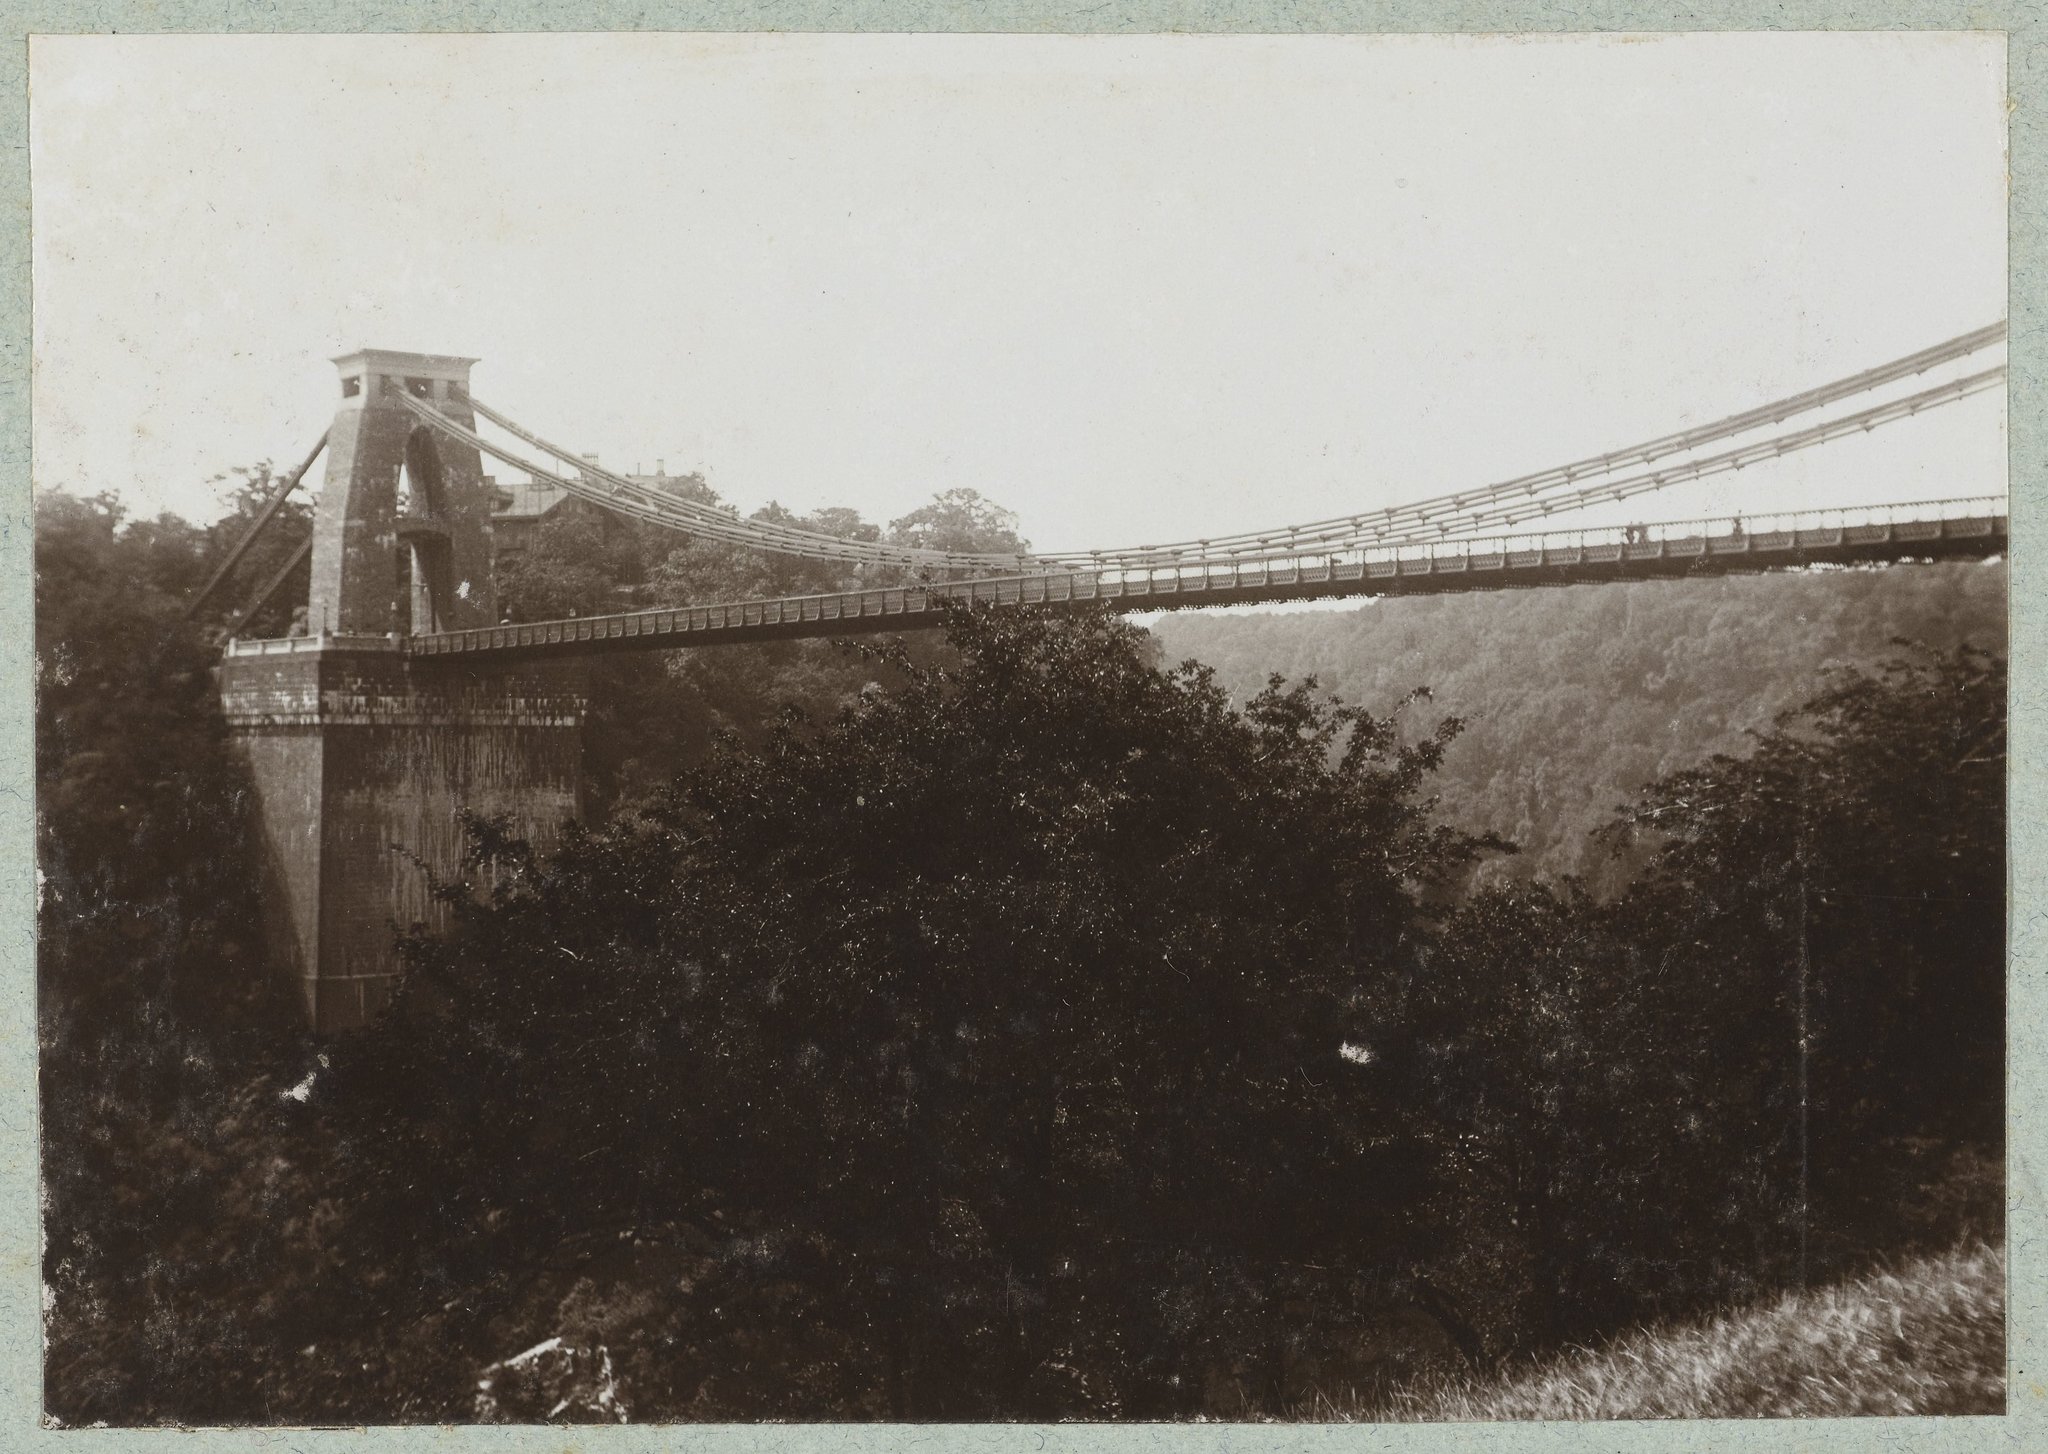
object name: photograph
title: Photographieën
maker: frits freerks fontein fz.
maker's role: fotograaf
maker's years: 1882-1928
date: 1901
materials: cardboard, paper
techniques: gelatin silver print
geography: netherlands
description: De Clifton Suspension Bridge ( hangbrug) over de kloof waarin de rivier de Avon loopt bij Bristol. Foto uit album 'Photographieën".